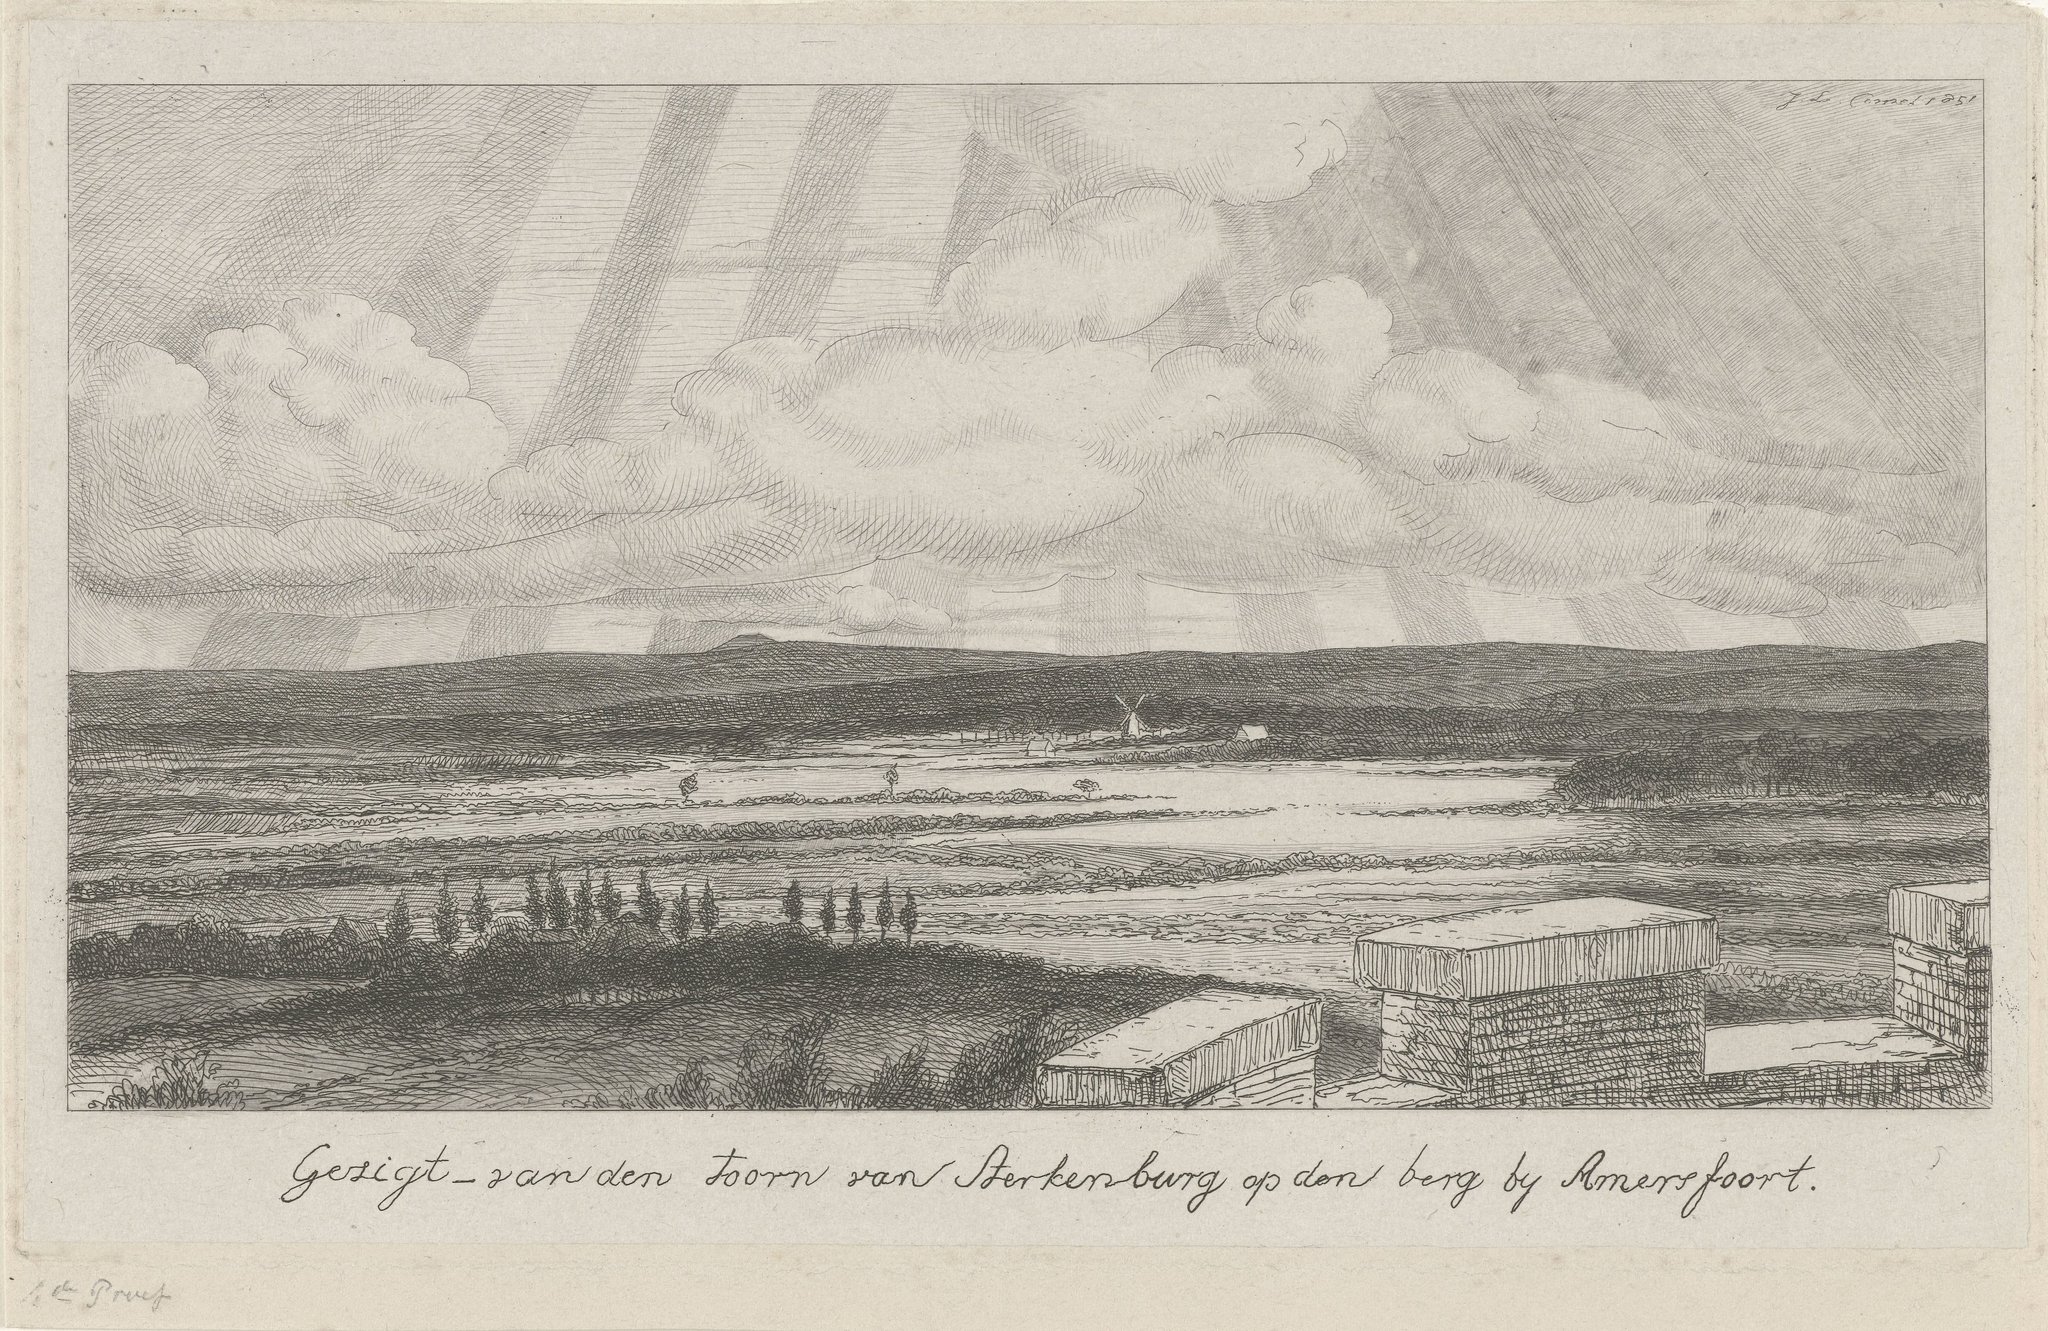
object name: print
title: Landschap rond Amersfoort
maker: jacobus ludovicus cornet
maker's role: draughtsman, print maker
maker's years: 1815-1882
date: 1851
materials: paper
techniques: etching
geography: leiden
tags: river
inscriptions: collector's mark: Lugt 2228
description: Gezicht op het landschap rond Amersfoort, gezien van op de toren van Ridderhofstad Sterkenburg. Op de voorgrond rechts de kantelen van het kasteel. De zon breekt door de wolken.